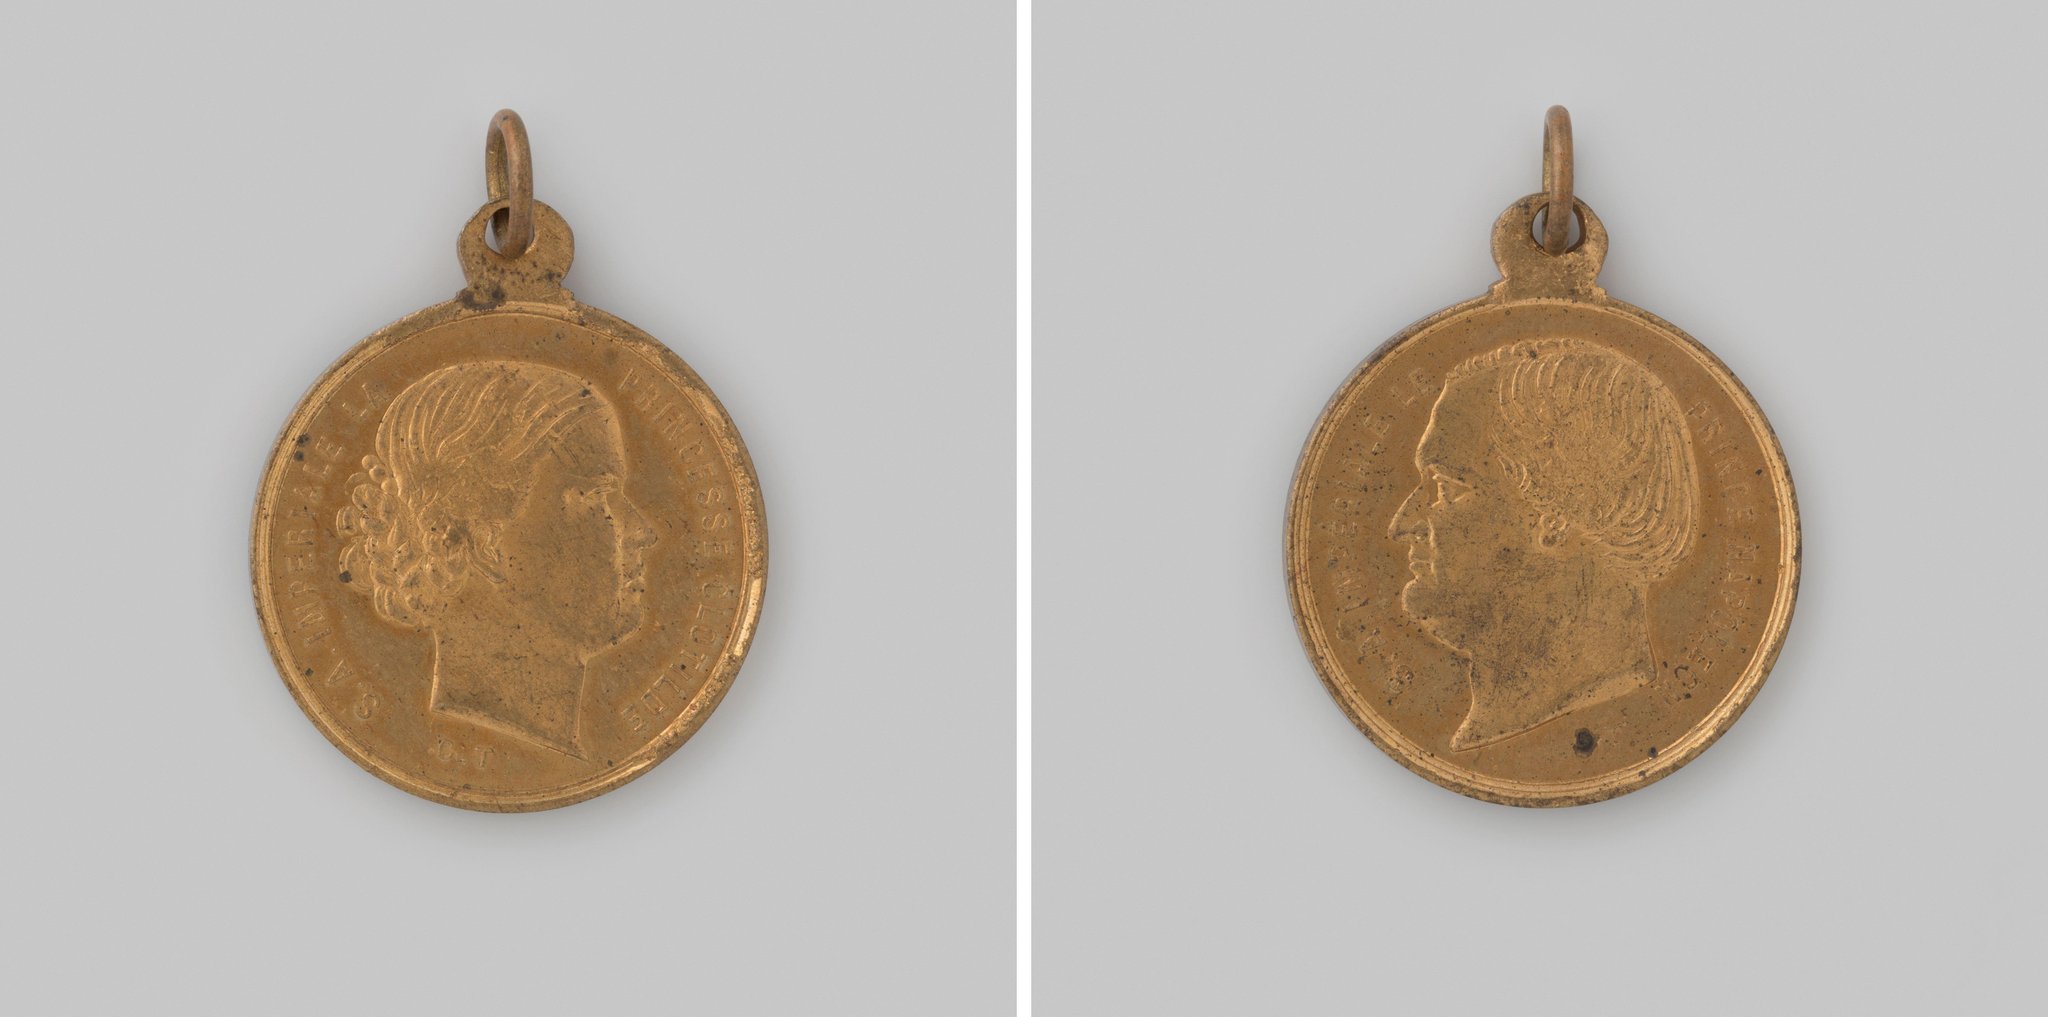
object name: history medal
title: Prins Napoleon en Prinses Clothilde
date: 1852-1871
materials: brass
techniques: striking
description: Verguld messing penning met oog en draagring, op de voorzijde het portret van Clothilde naar rechts met omschrift, op de keerzijde het portret van Napoleon naar links met omschrift.